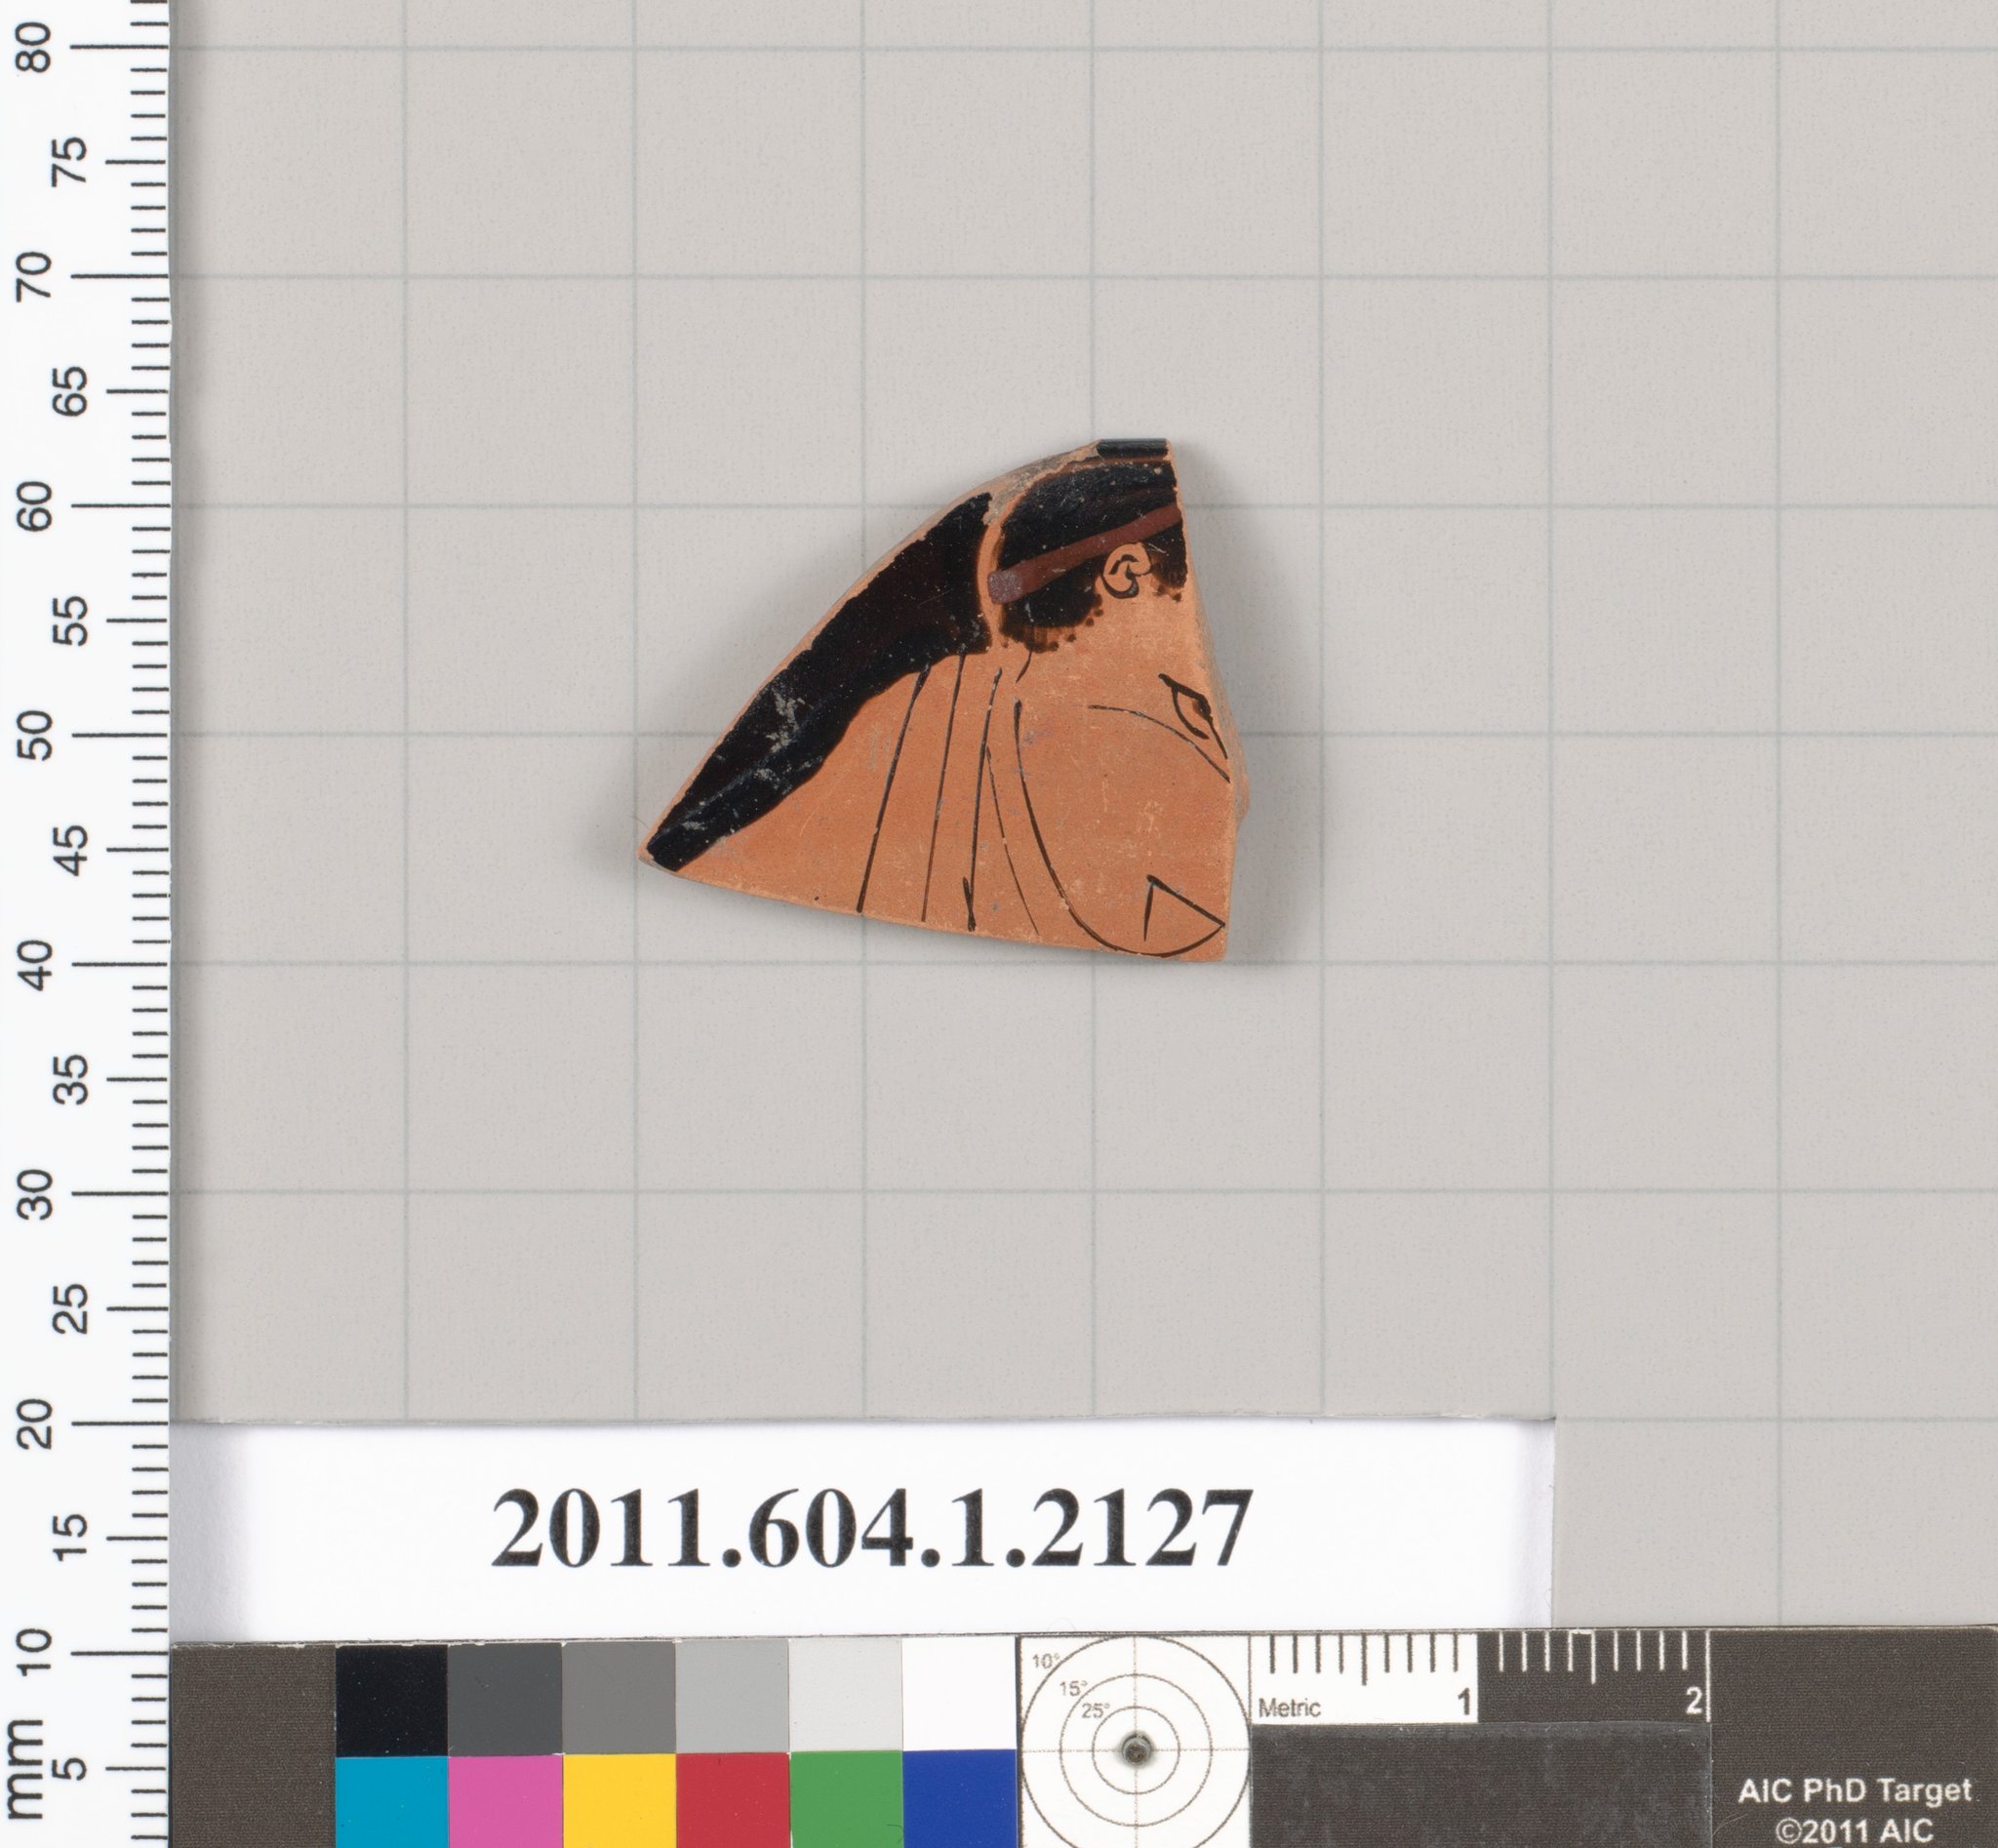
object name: kylix fragment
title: Terracotta rim fragment of a kylix (drinking cup)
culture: greek, attic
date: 475-451 BCE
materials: terracotta